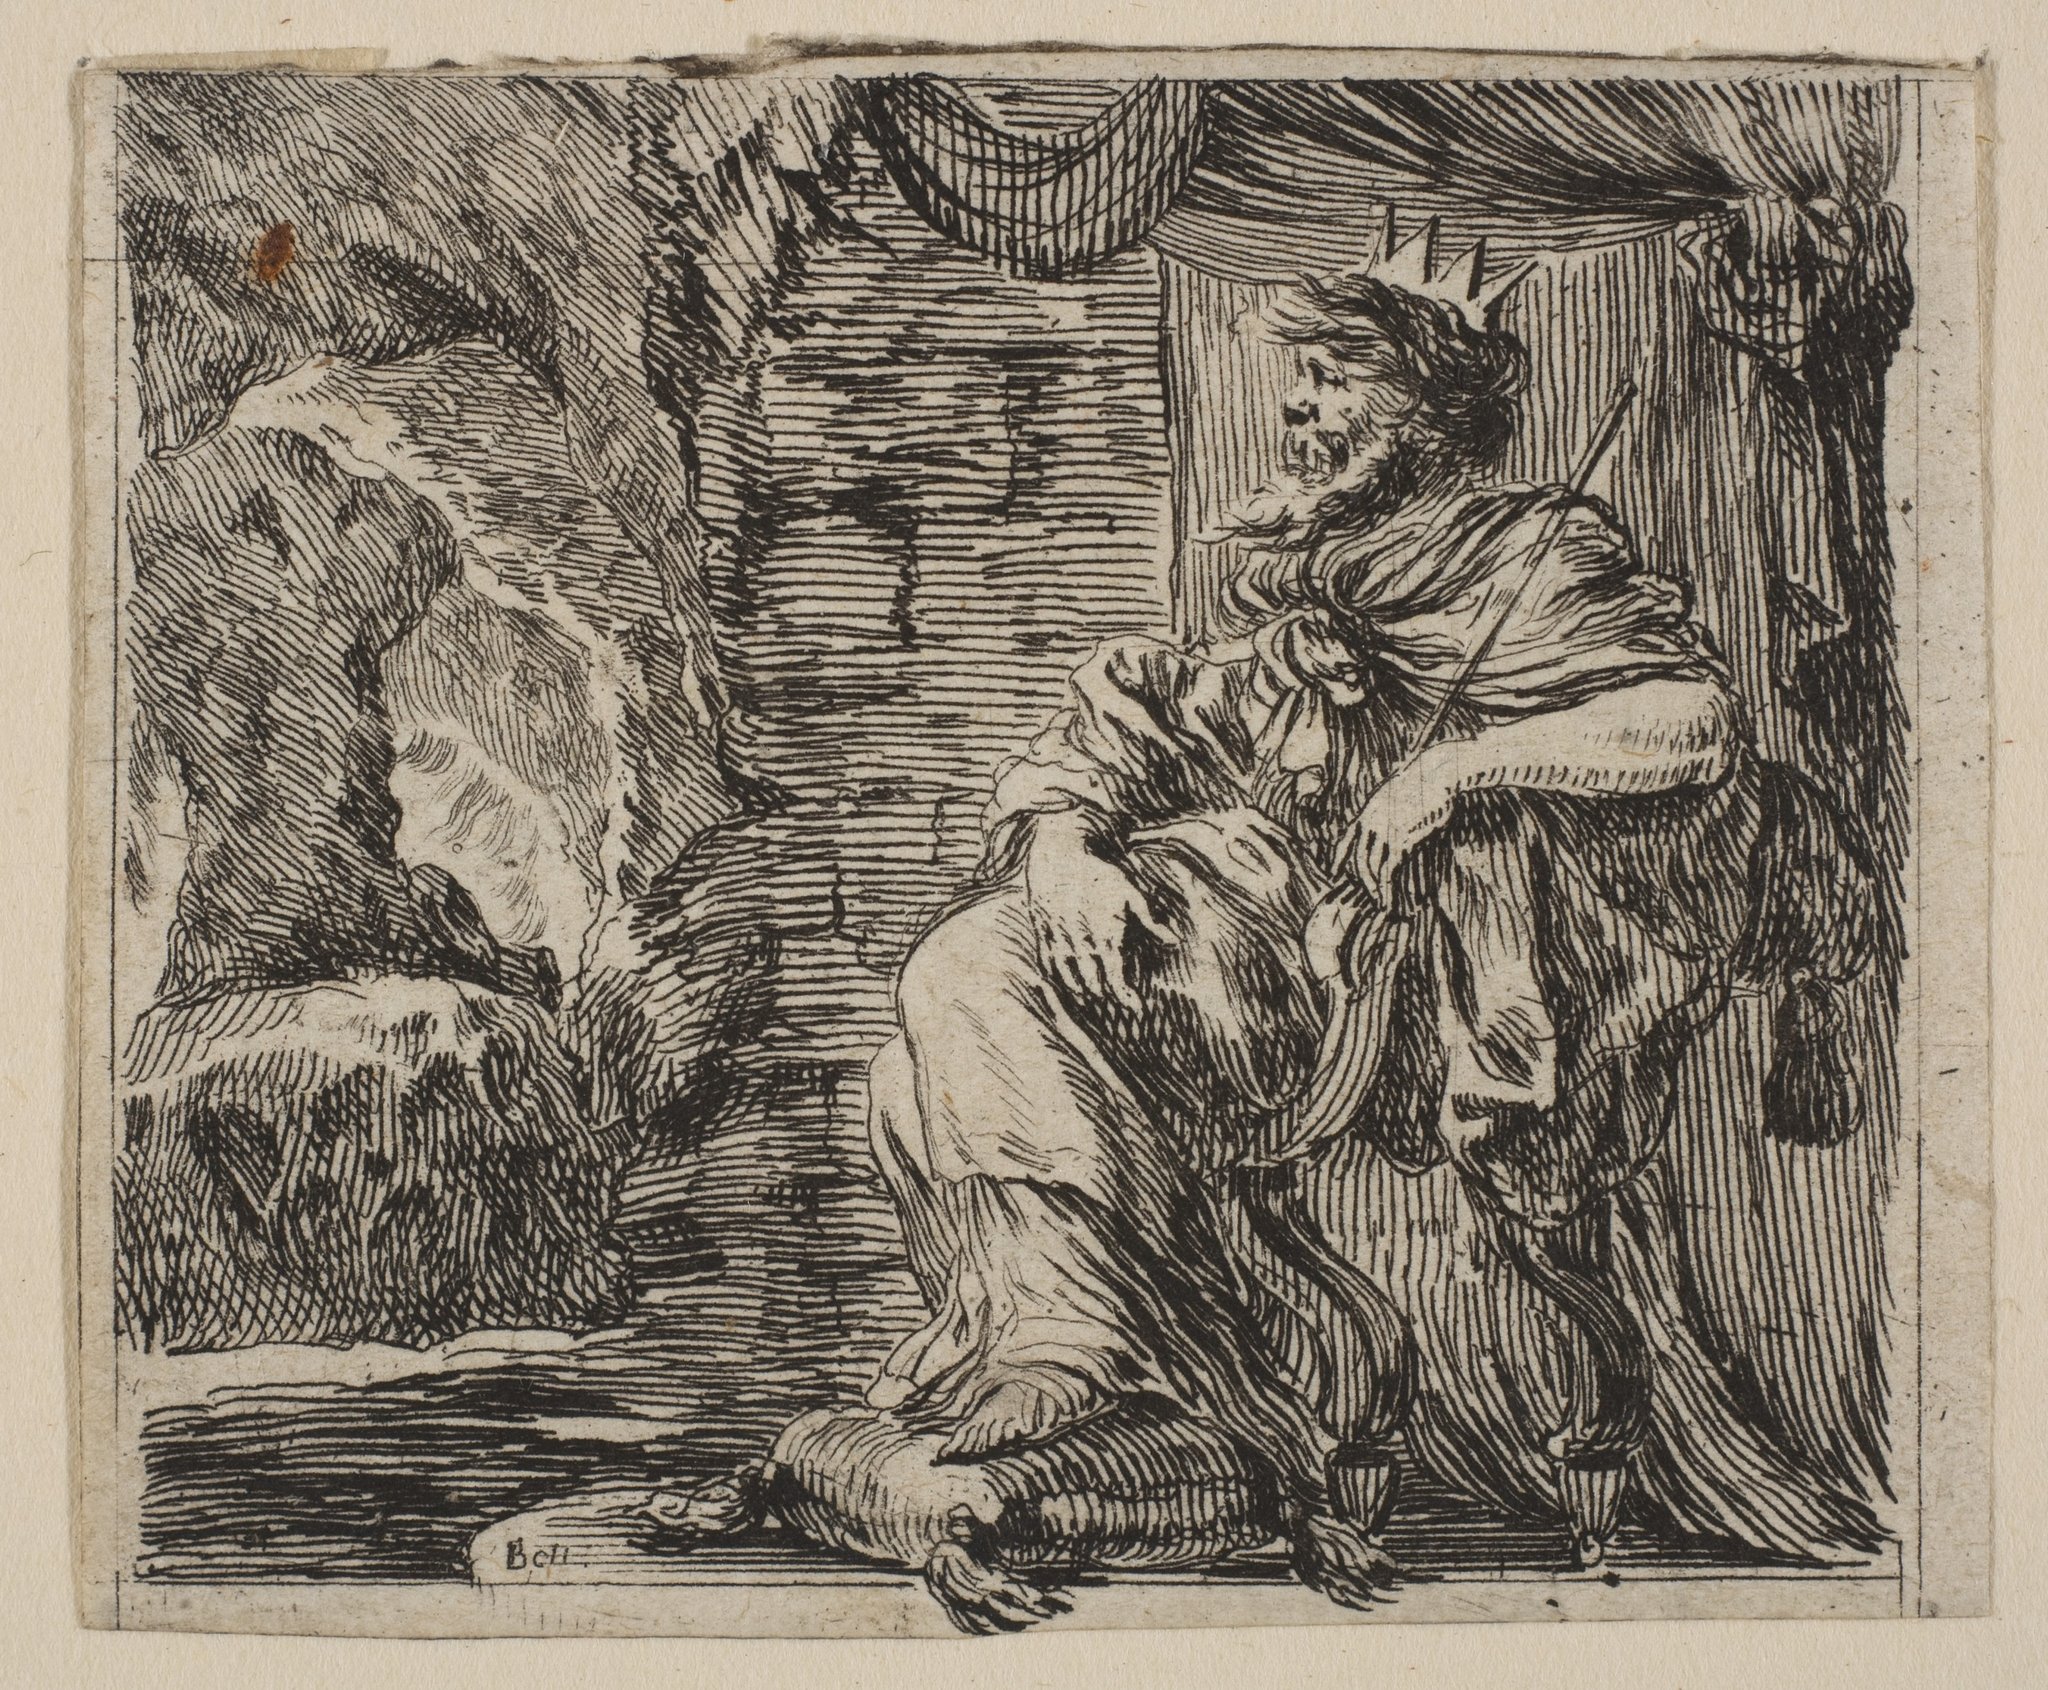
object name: print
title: Pluto, from 'Game of Mythology' (Jeu de la Mythologie)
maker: stefano della bella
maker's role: artist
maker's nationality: italian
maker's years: 1610-1664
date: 1644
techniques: etching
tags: men,pluto